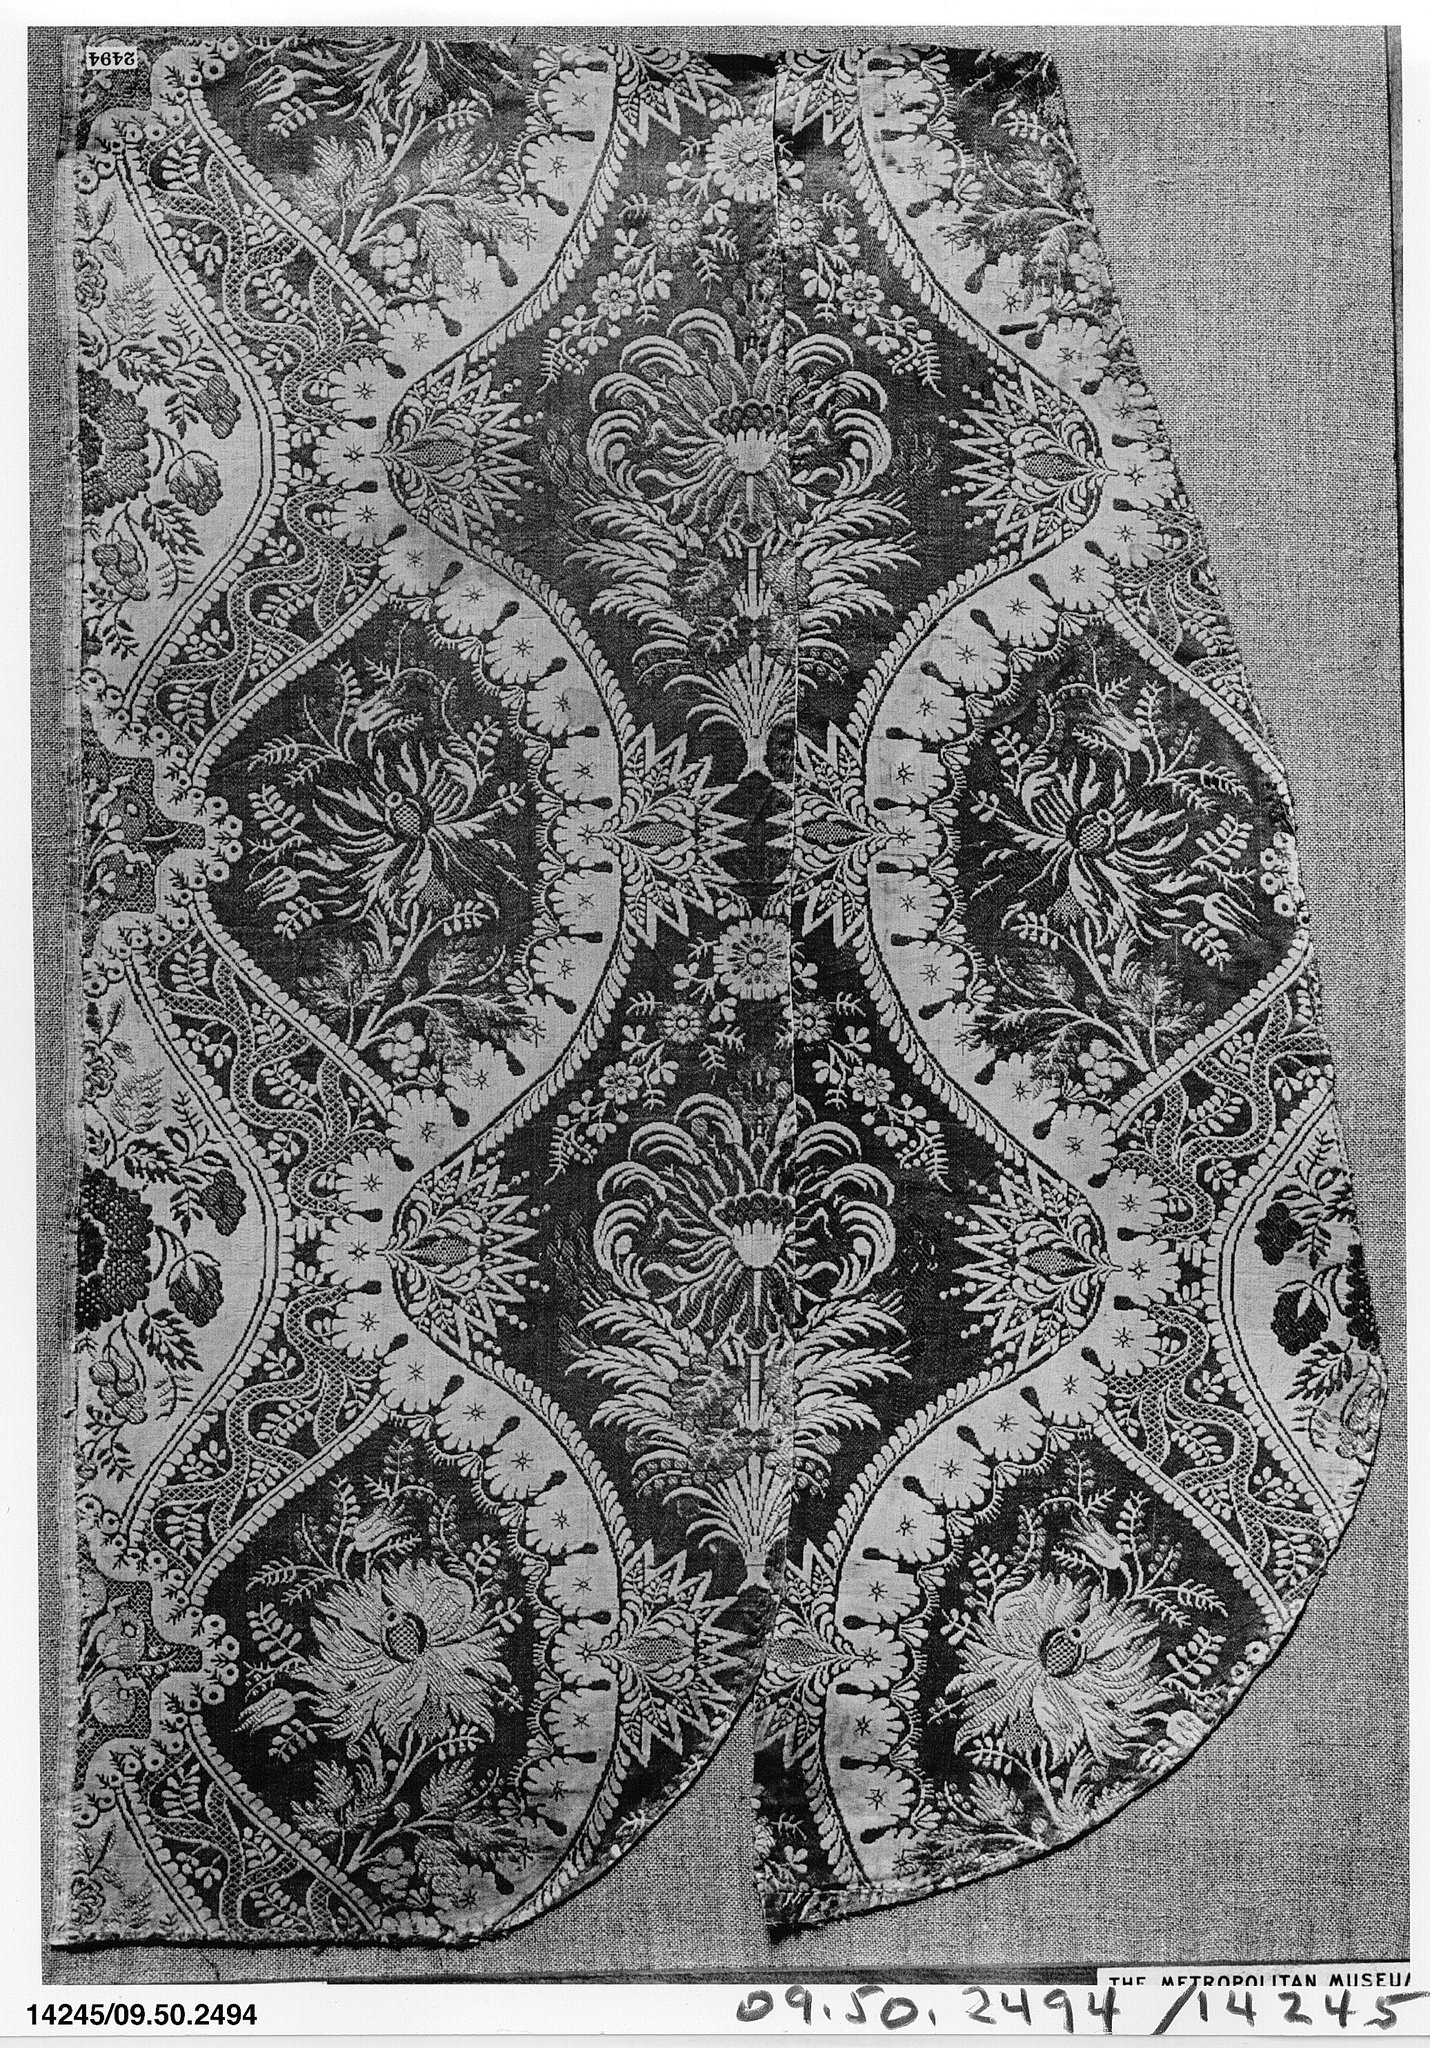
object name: piece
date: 1720-1725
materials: silk